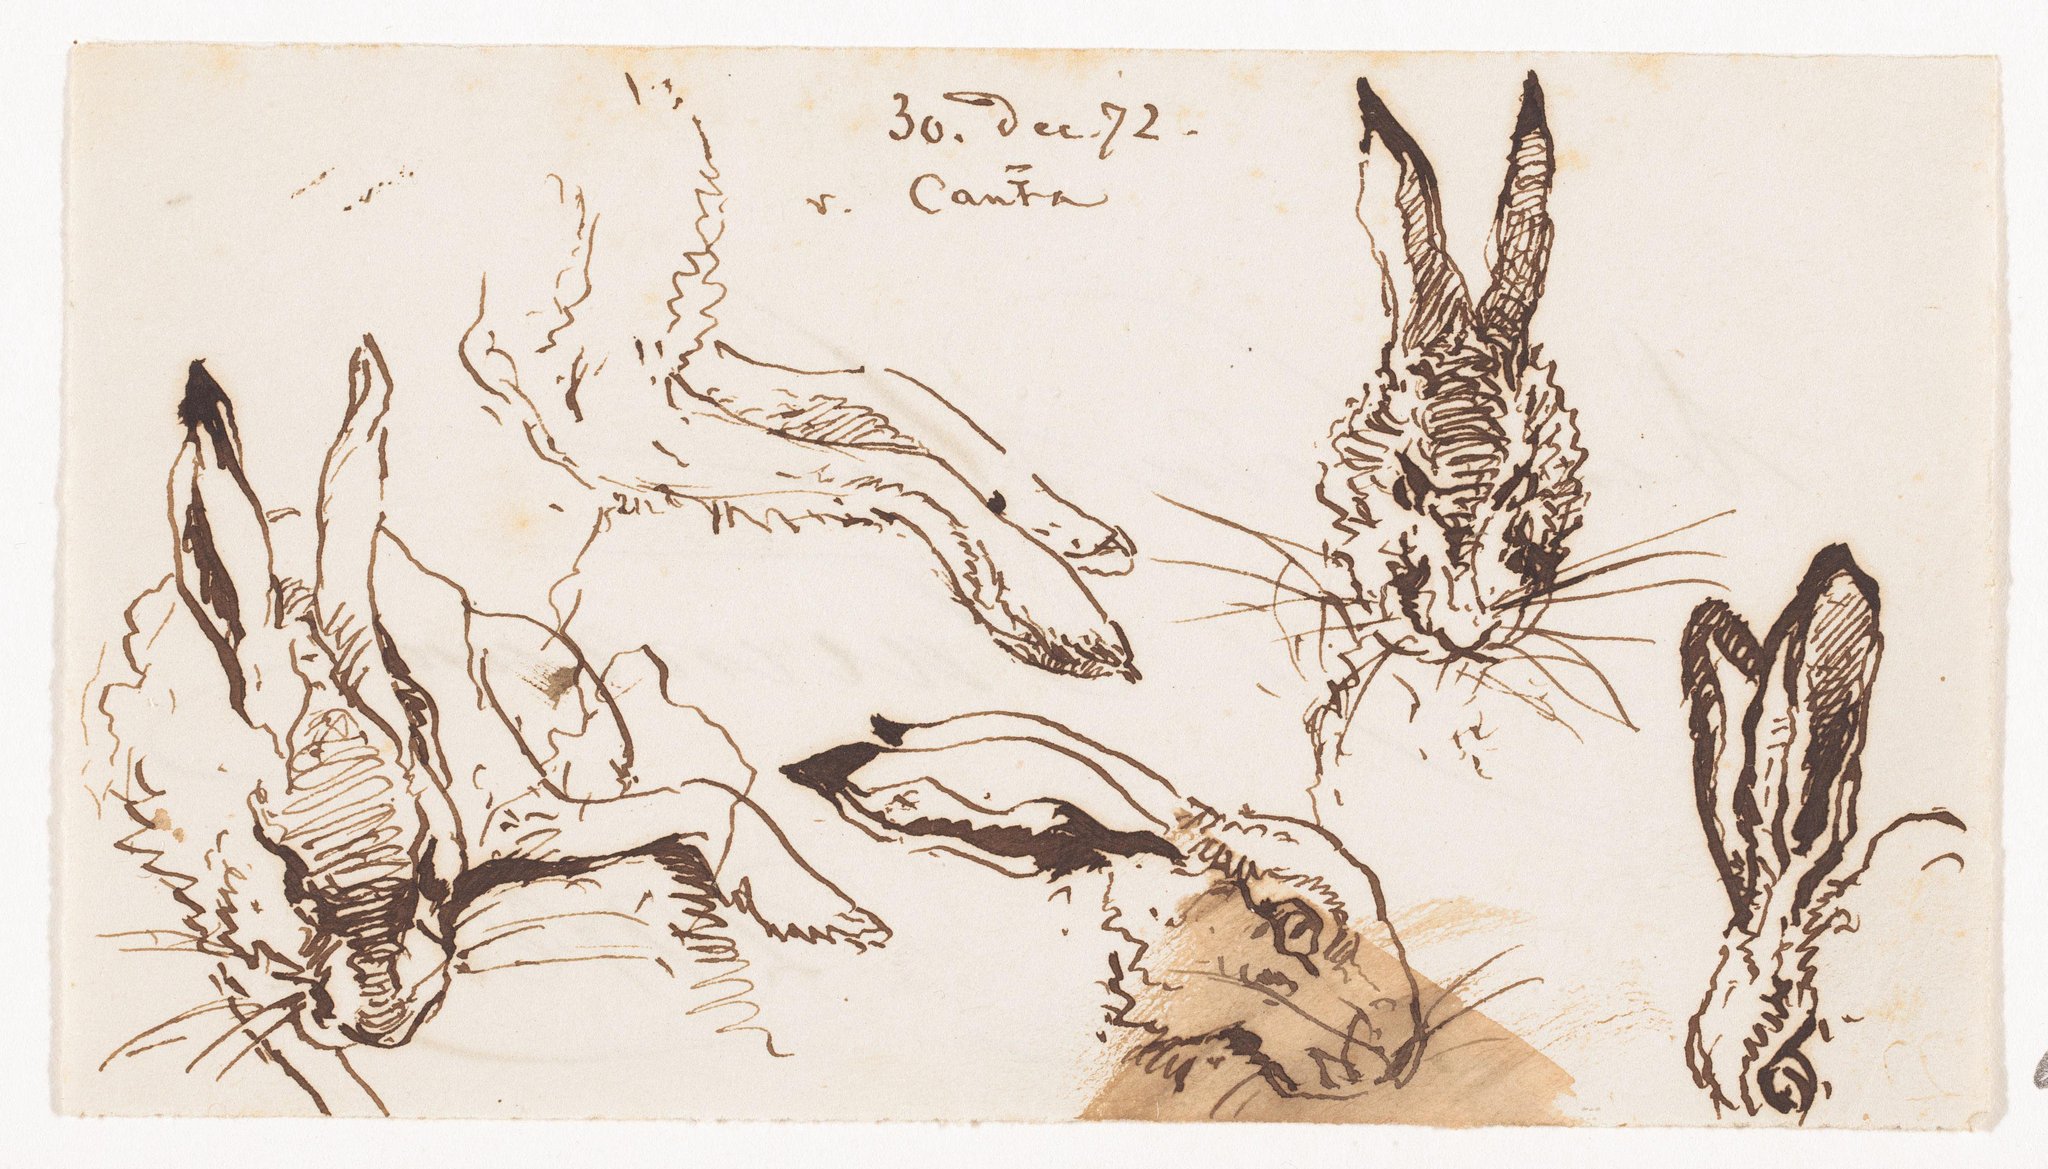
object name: drawing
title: Hazen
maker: johannes tavenraat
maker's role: draughtsman, painter, print maker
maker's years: 1809-1881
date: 1870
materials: ink, paper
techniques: pen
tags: rodents: hare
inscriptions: date: ‘30. dec. 72. / v. Canta’, collector's mark: Lugt 2228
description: Hazen. Getekend op de achterzijde van een bief of envelop gericht aan J. Tavenraat.